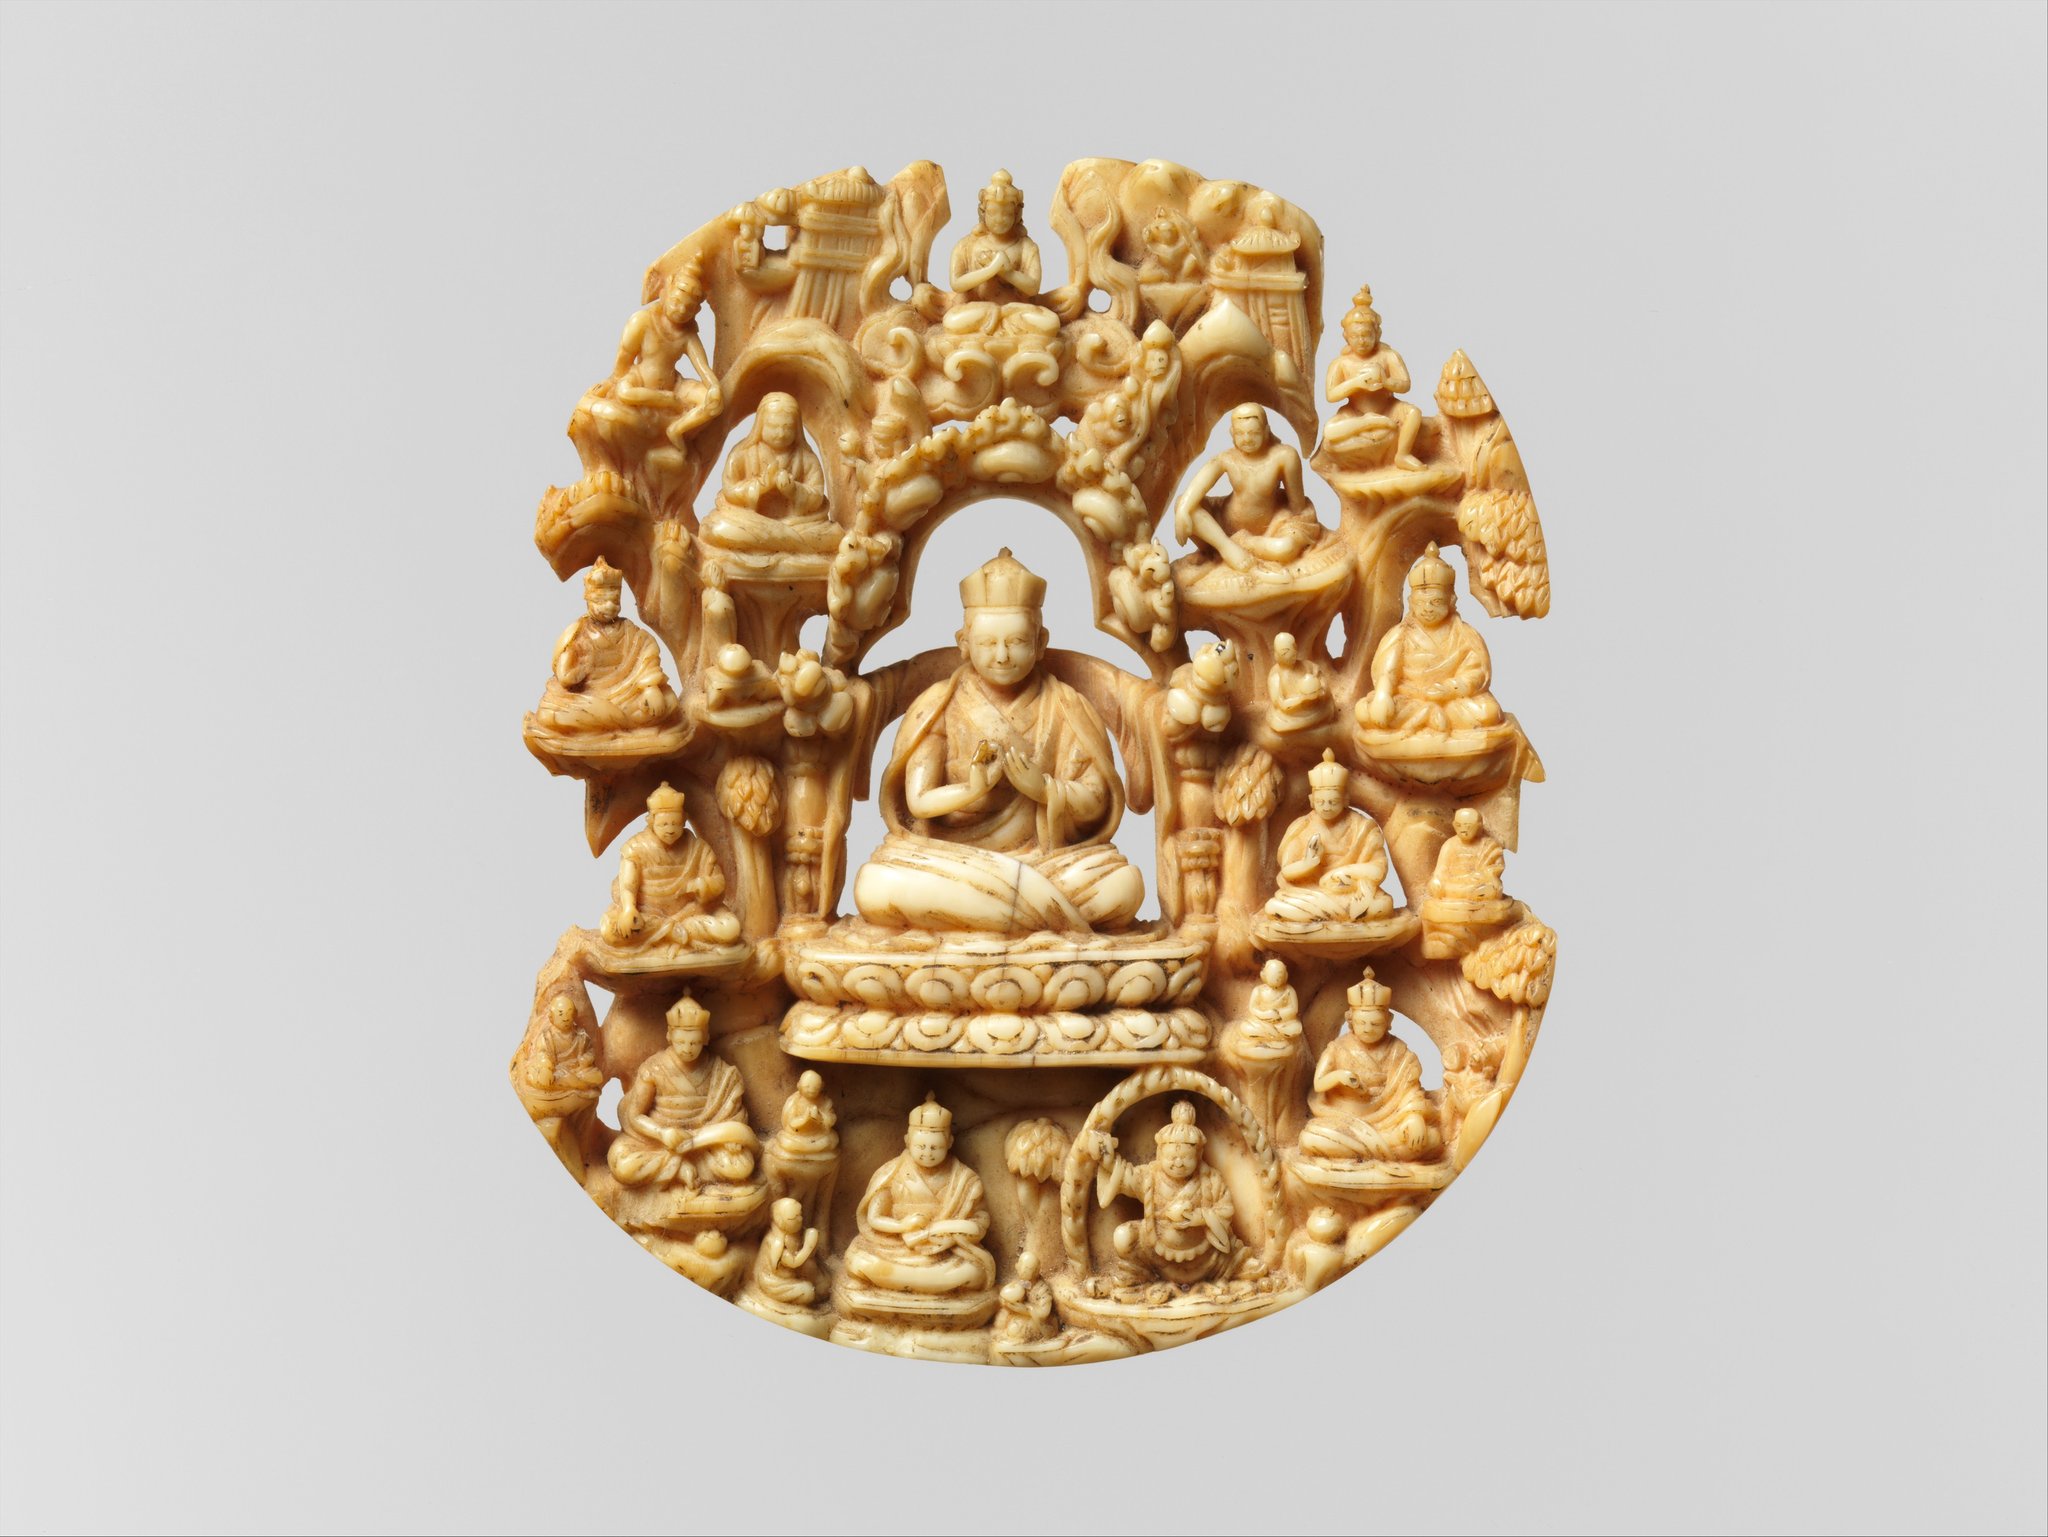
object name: roundel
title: Roundel with Karma Lineage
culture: tibetan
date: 1501-1600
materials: ivory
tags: men,buddhism,monks